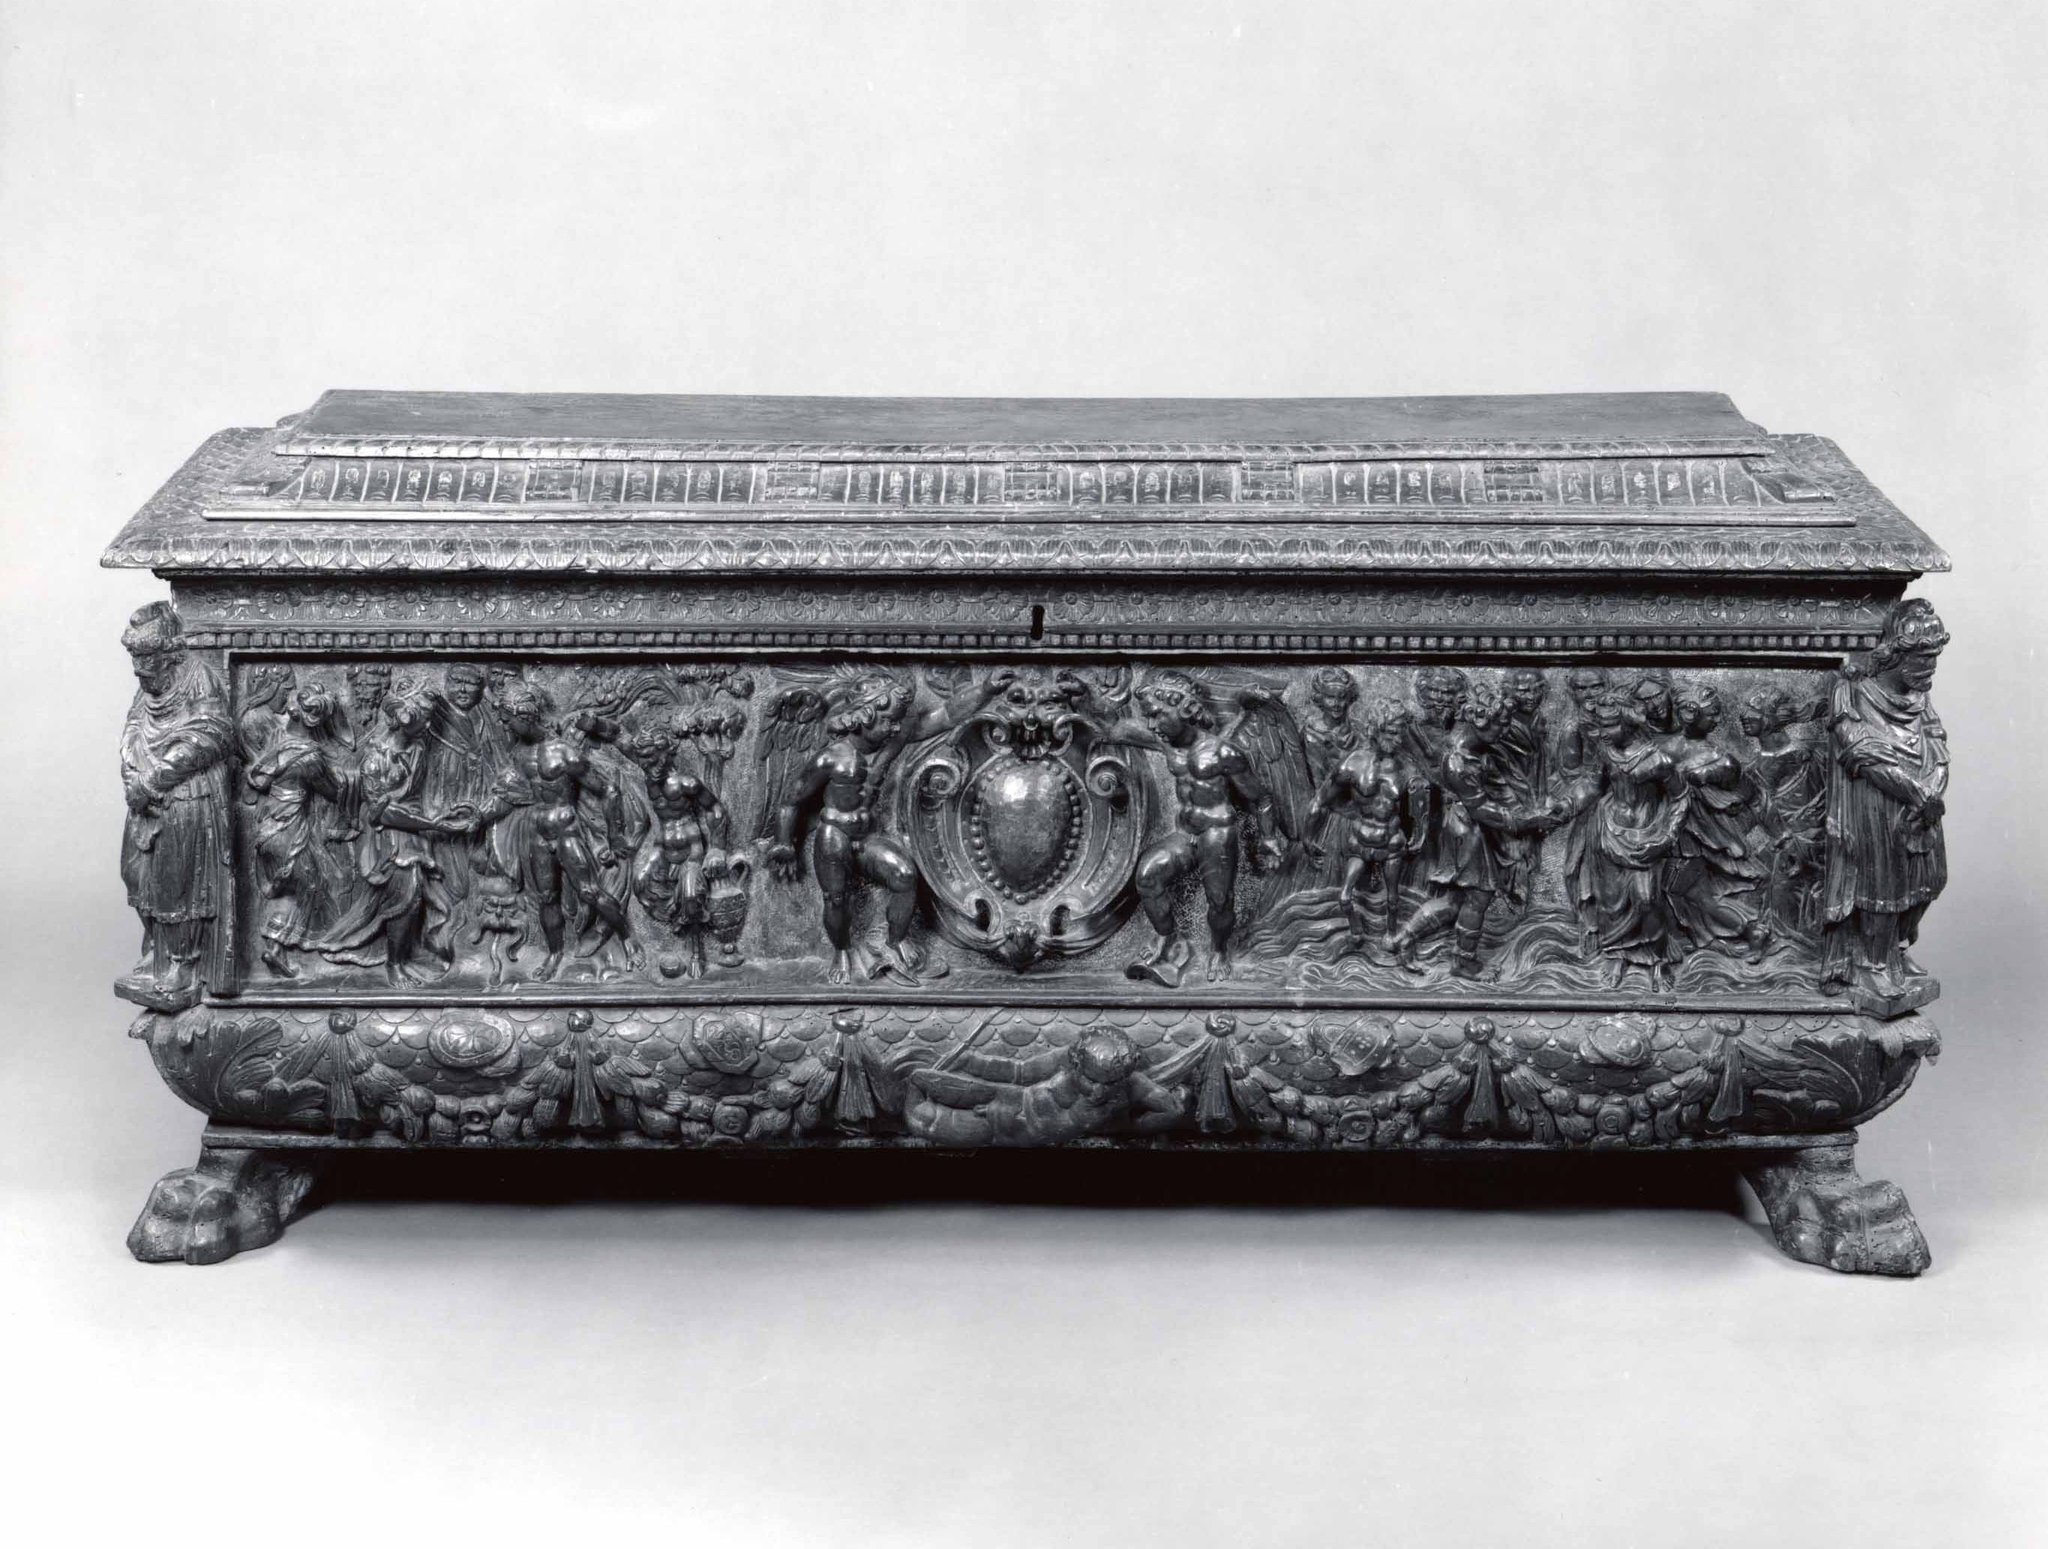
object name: cassone chest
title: Cassone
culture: italian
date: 1575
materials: iron, wood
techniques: carving, gilding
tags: men,women,putti